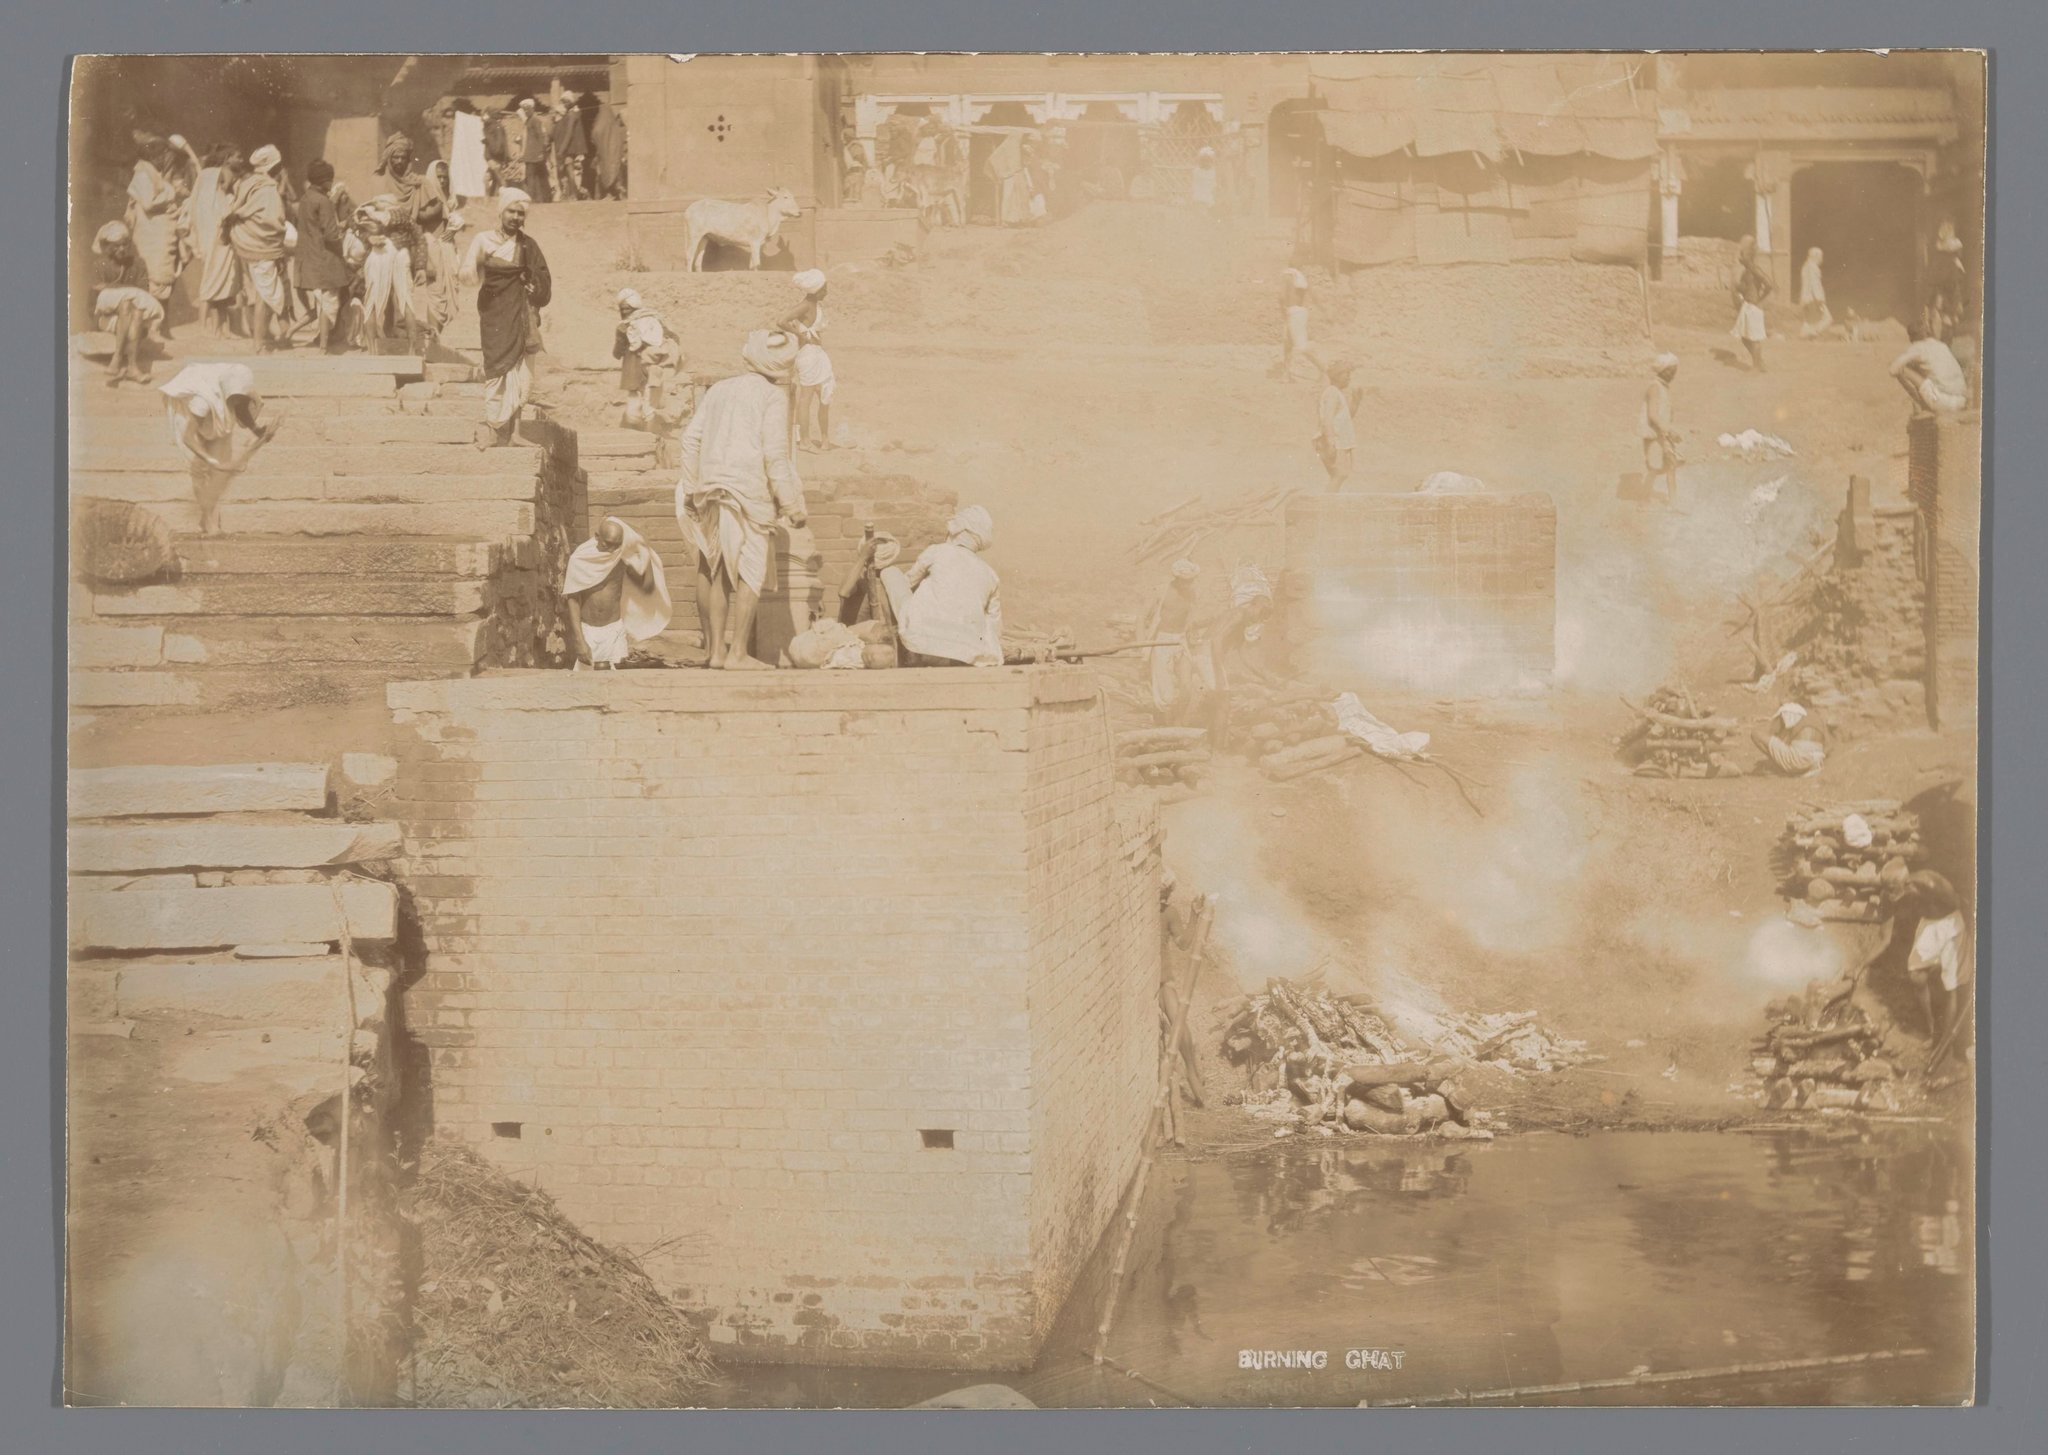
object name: photograph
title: Ritual cremation stacks on the Ganges on the ghats of Varanasi, Uttar Pradesh, India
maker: Anonymous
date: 1890-1920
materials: paper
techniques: gelatin silver print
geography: varanasi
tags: places and objects of worship ~ hinduism, buddhism, jainism, body-burning, cremation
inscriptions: inscription: ‘Benares’, title: ‘Burning Ghat’